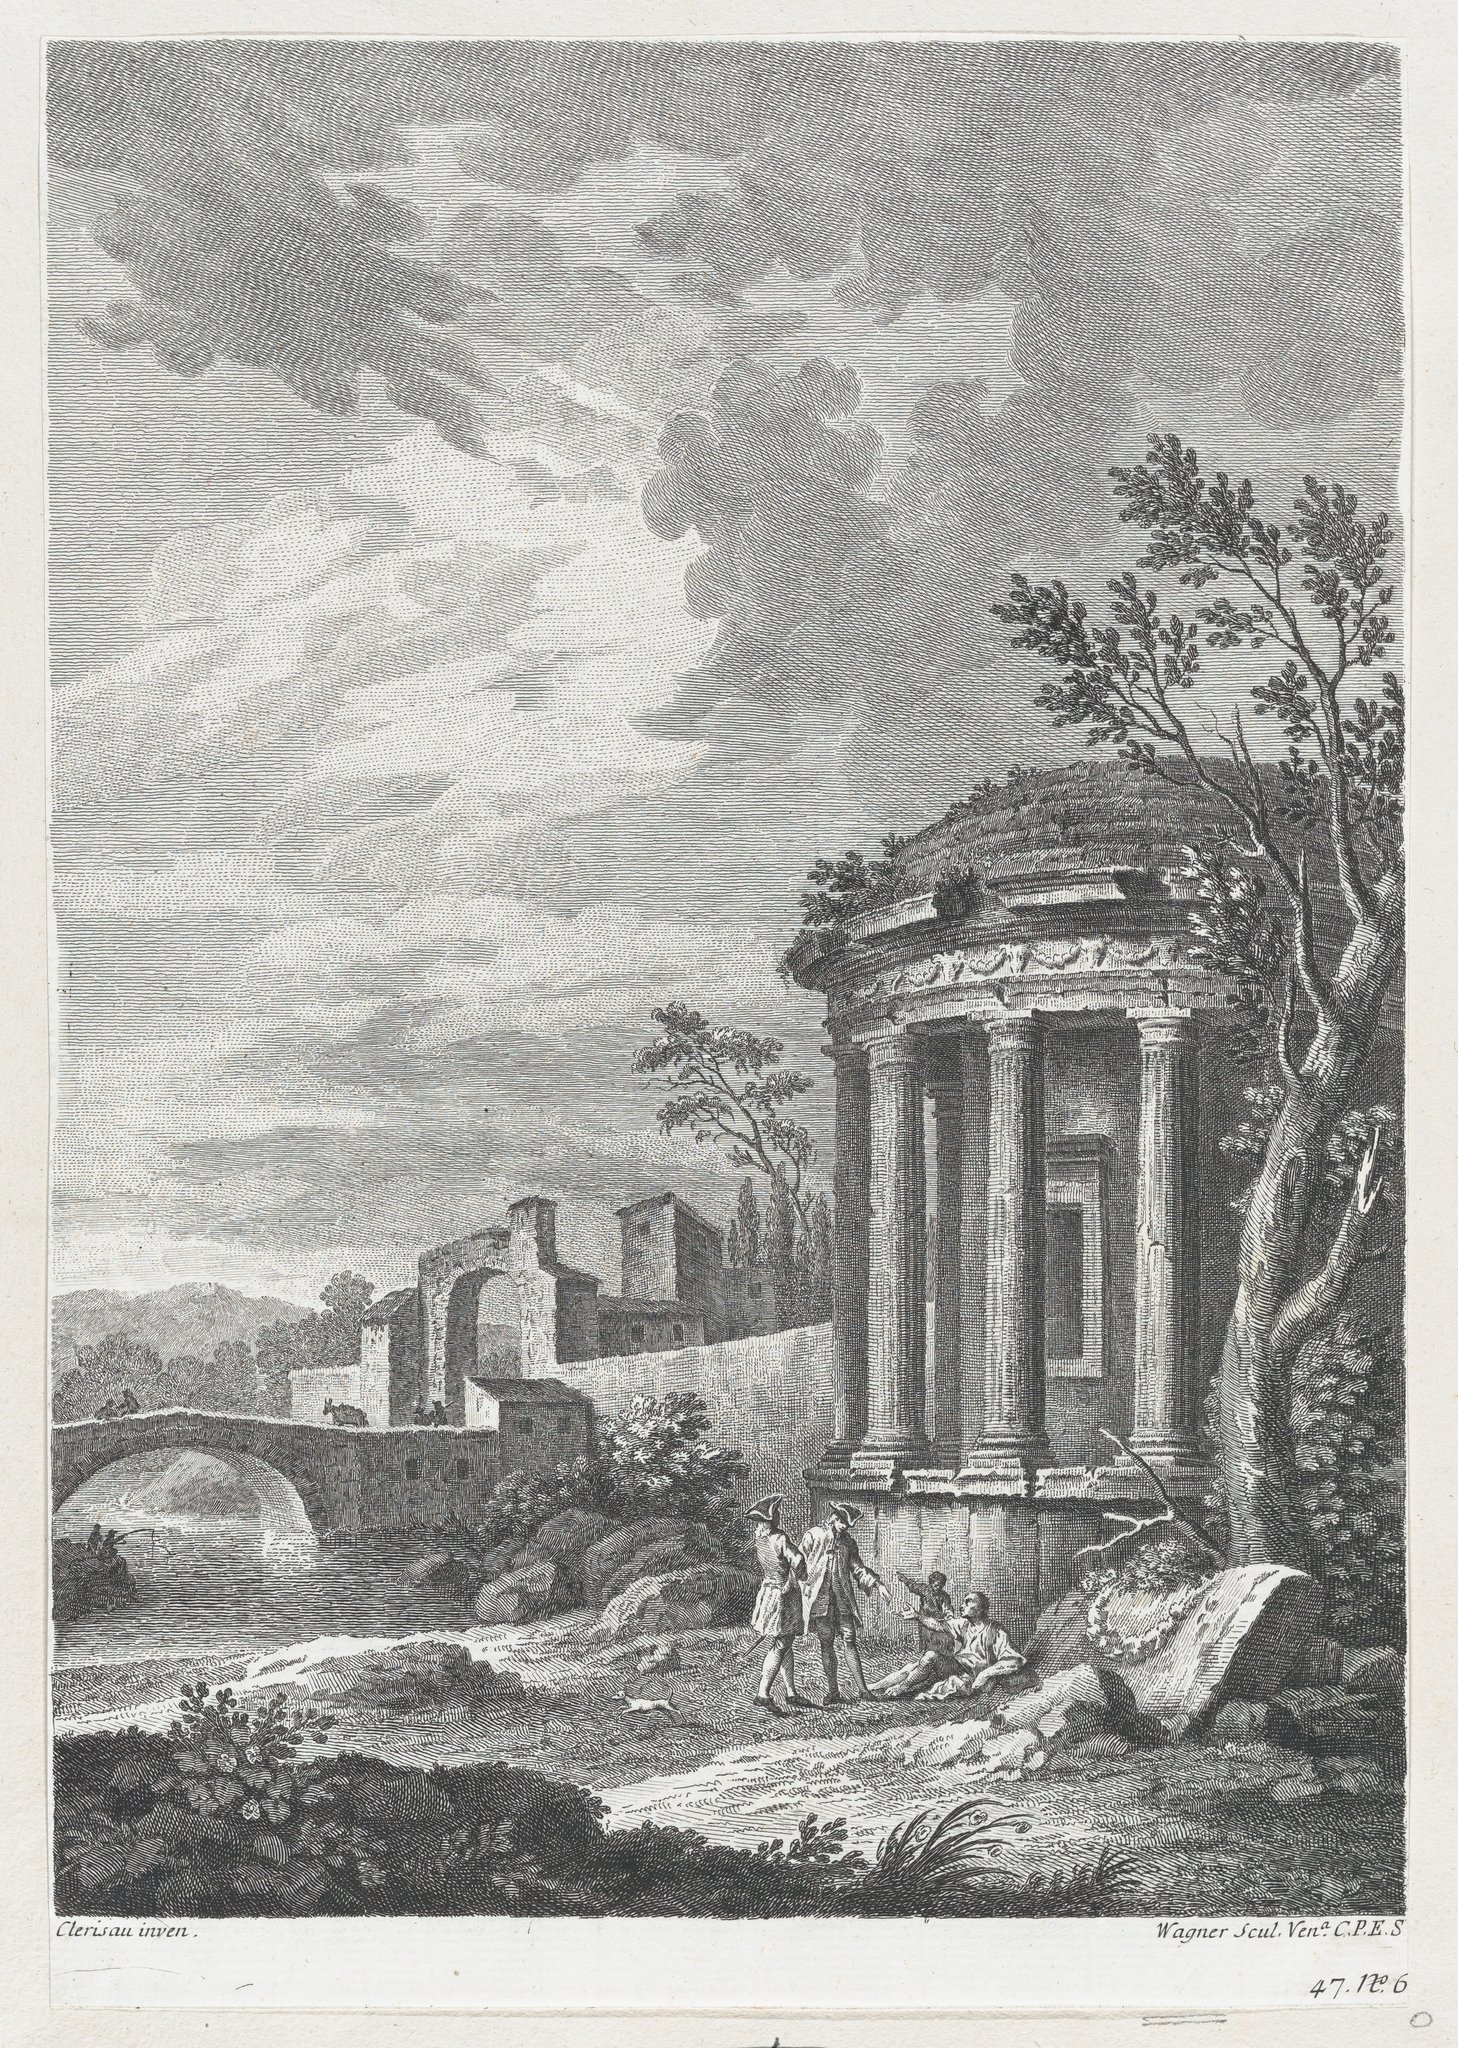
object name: print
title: Landscape with Temple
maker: joseph wagner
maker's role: artist and publisher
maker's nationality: italian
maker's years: 1706-1780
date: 1750-1770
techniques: etching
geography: venice